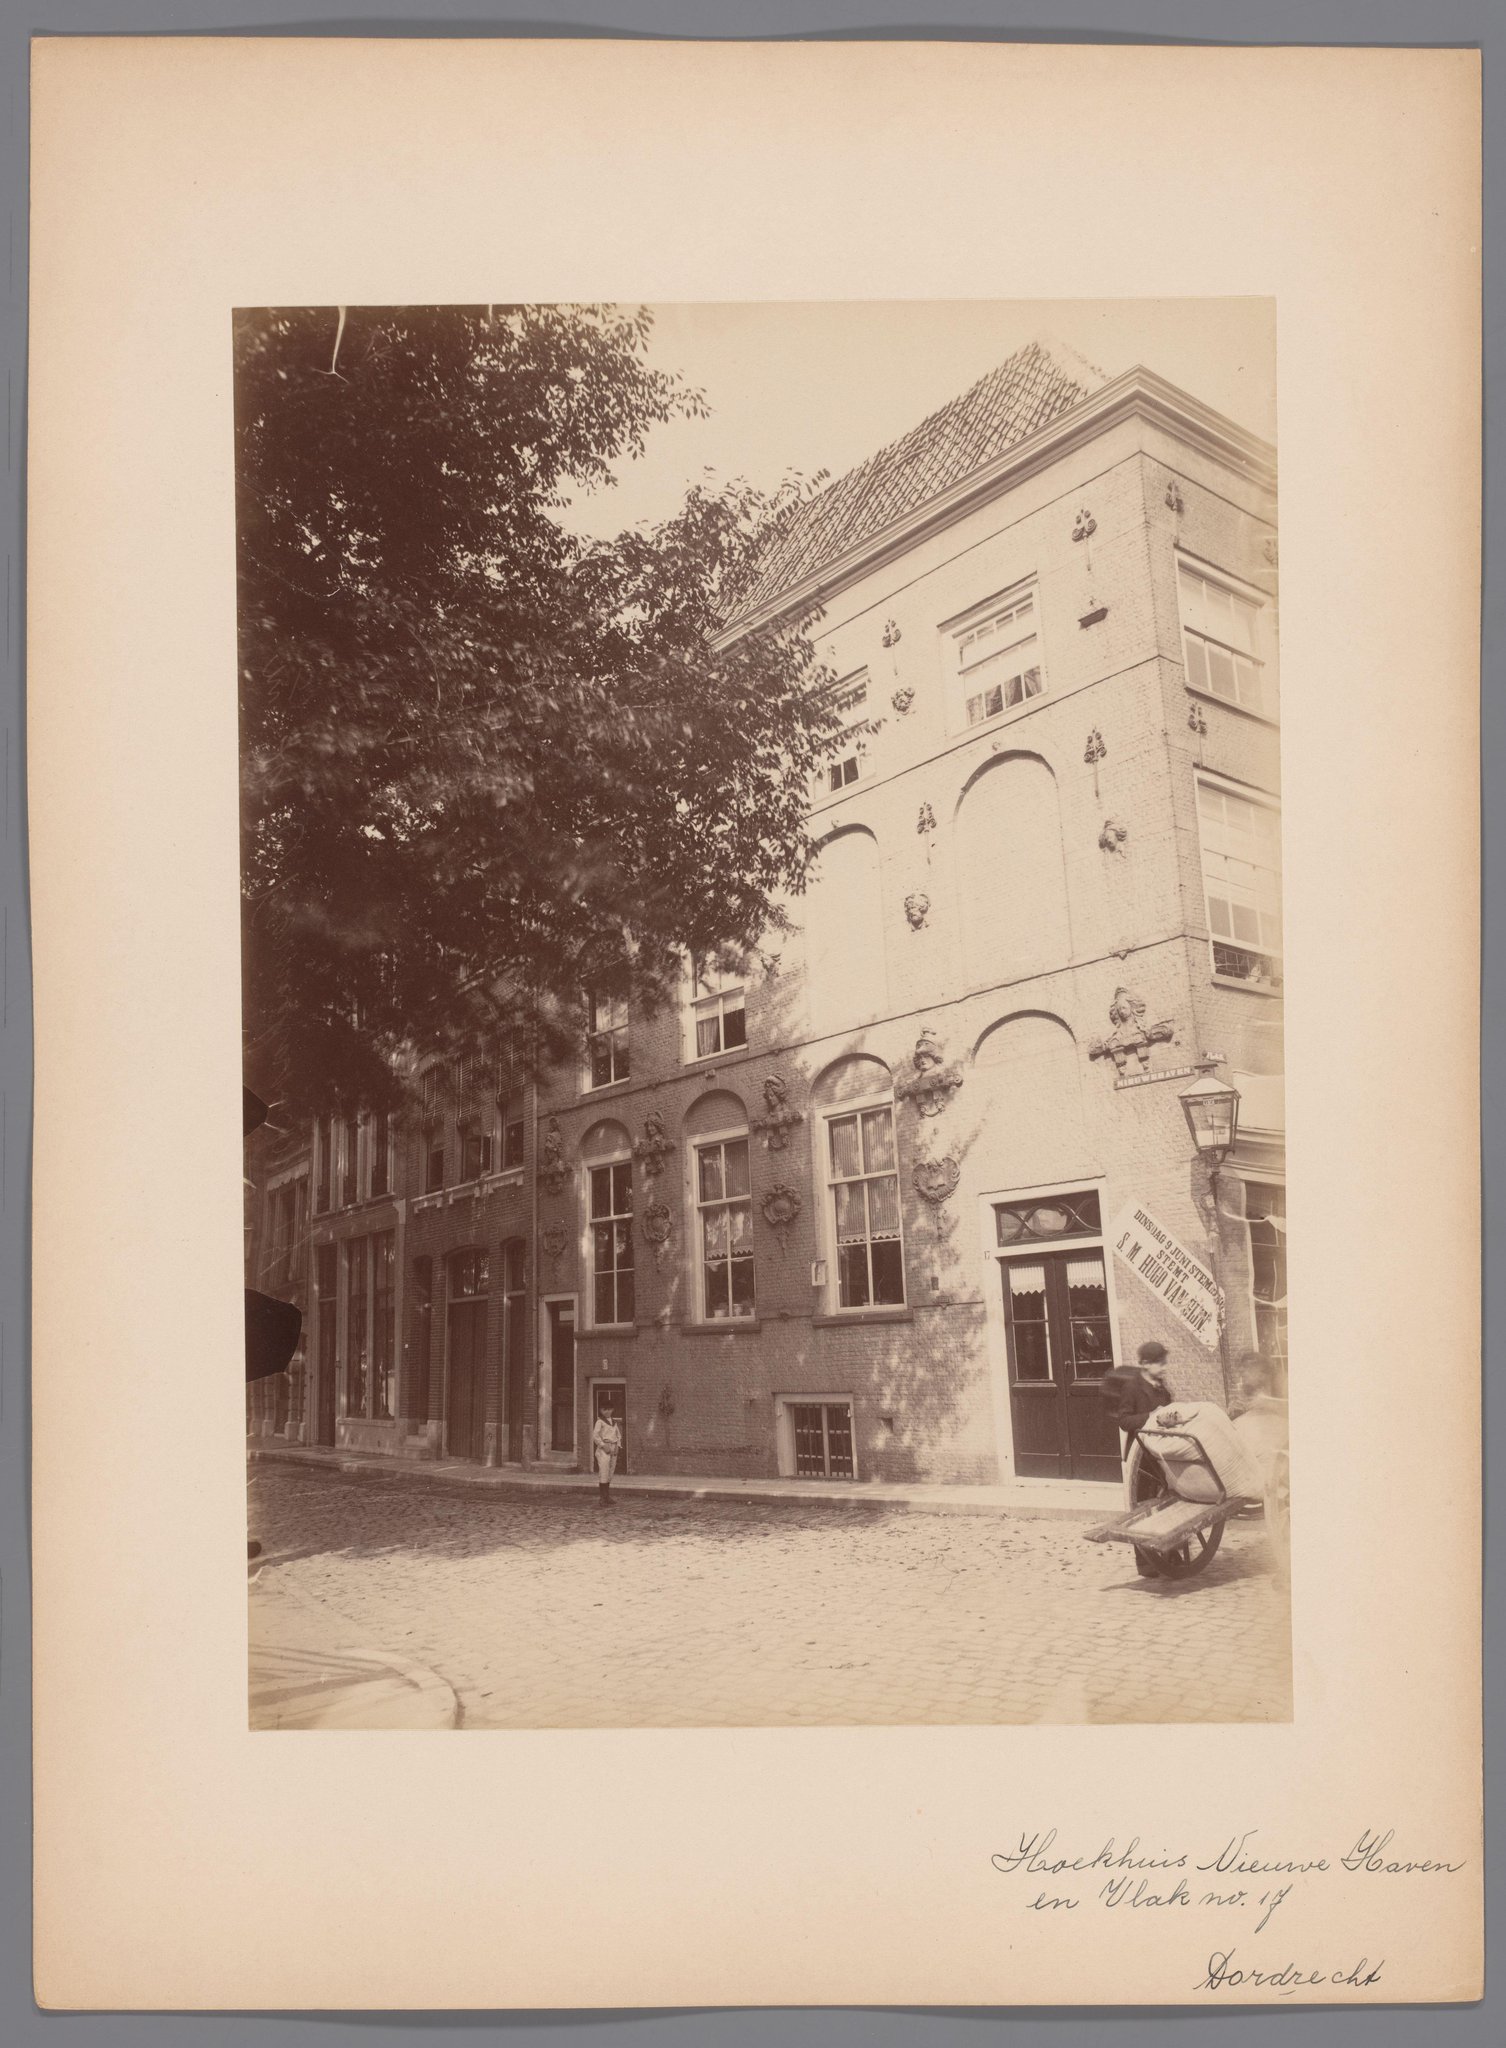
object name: photograph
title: Hoekhuis van de Nieuwe Haven en de Vlak te Dordrecht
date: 1890-1910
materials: cardboard, photographic support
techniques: albumen print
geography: nieuwe haven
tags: urban housing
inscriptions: annotation: ‘Dordrecht/ Hoekhuis Nieuwe Haven & Vlak No. 17’, annotation: ‘Hoekhuis Nieuwe Haven en Vlak no. 17/ Dordrecht’